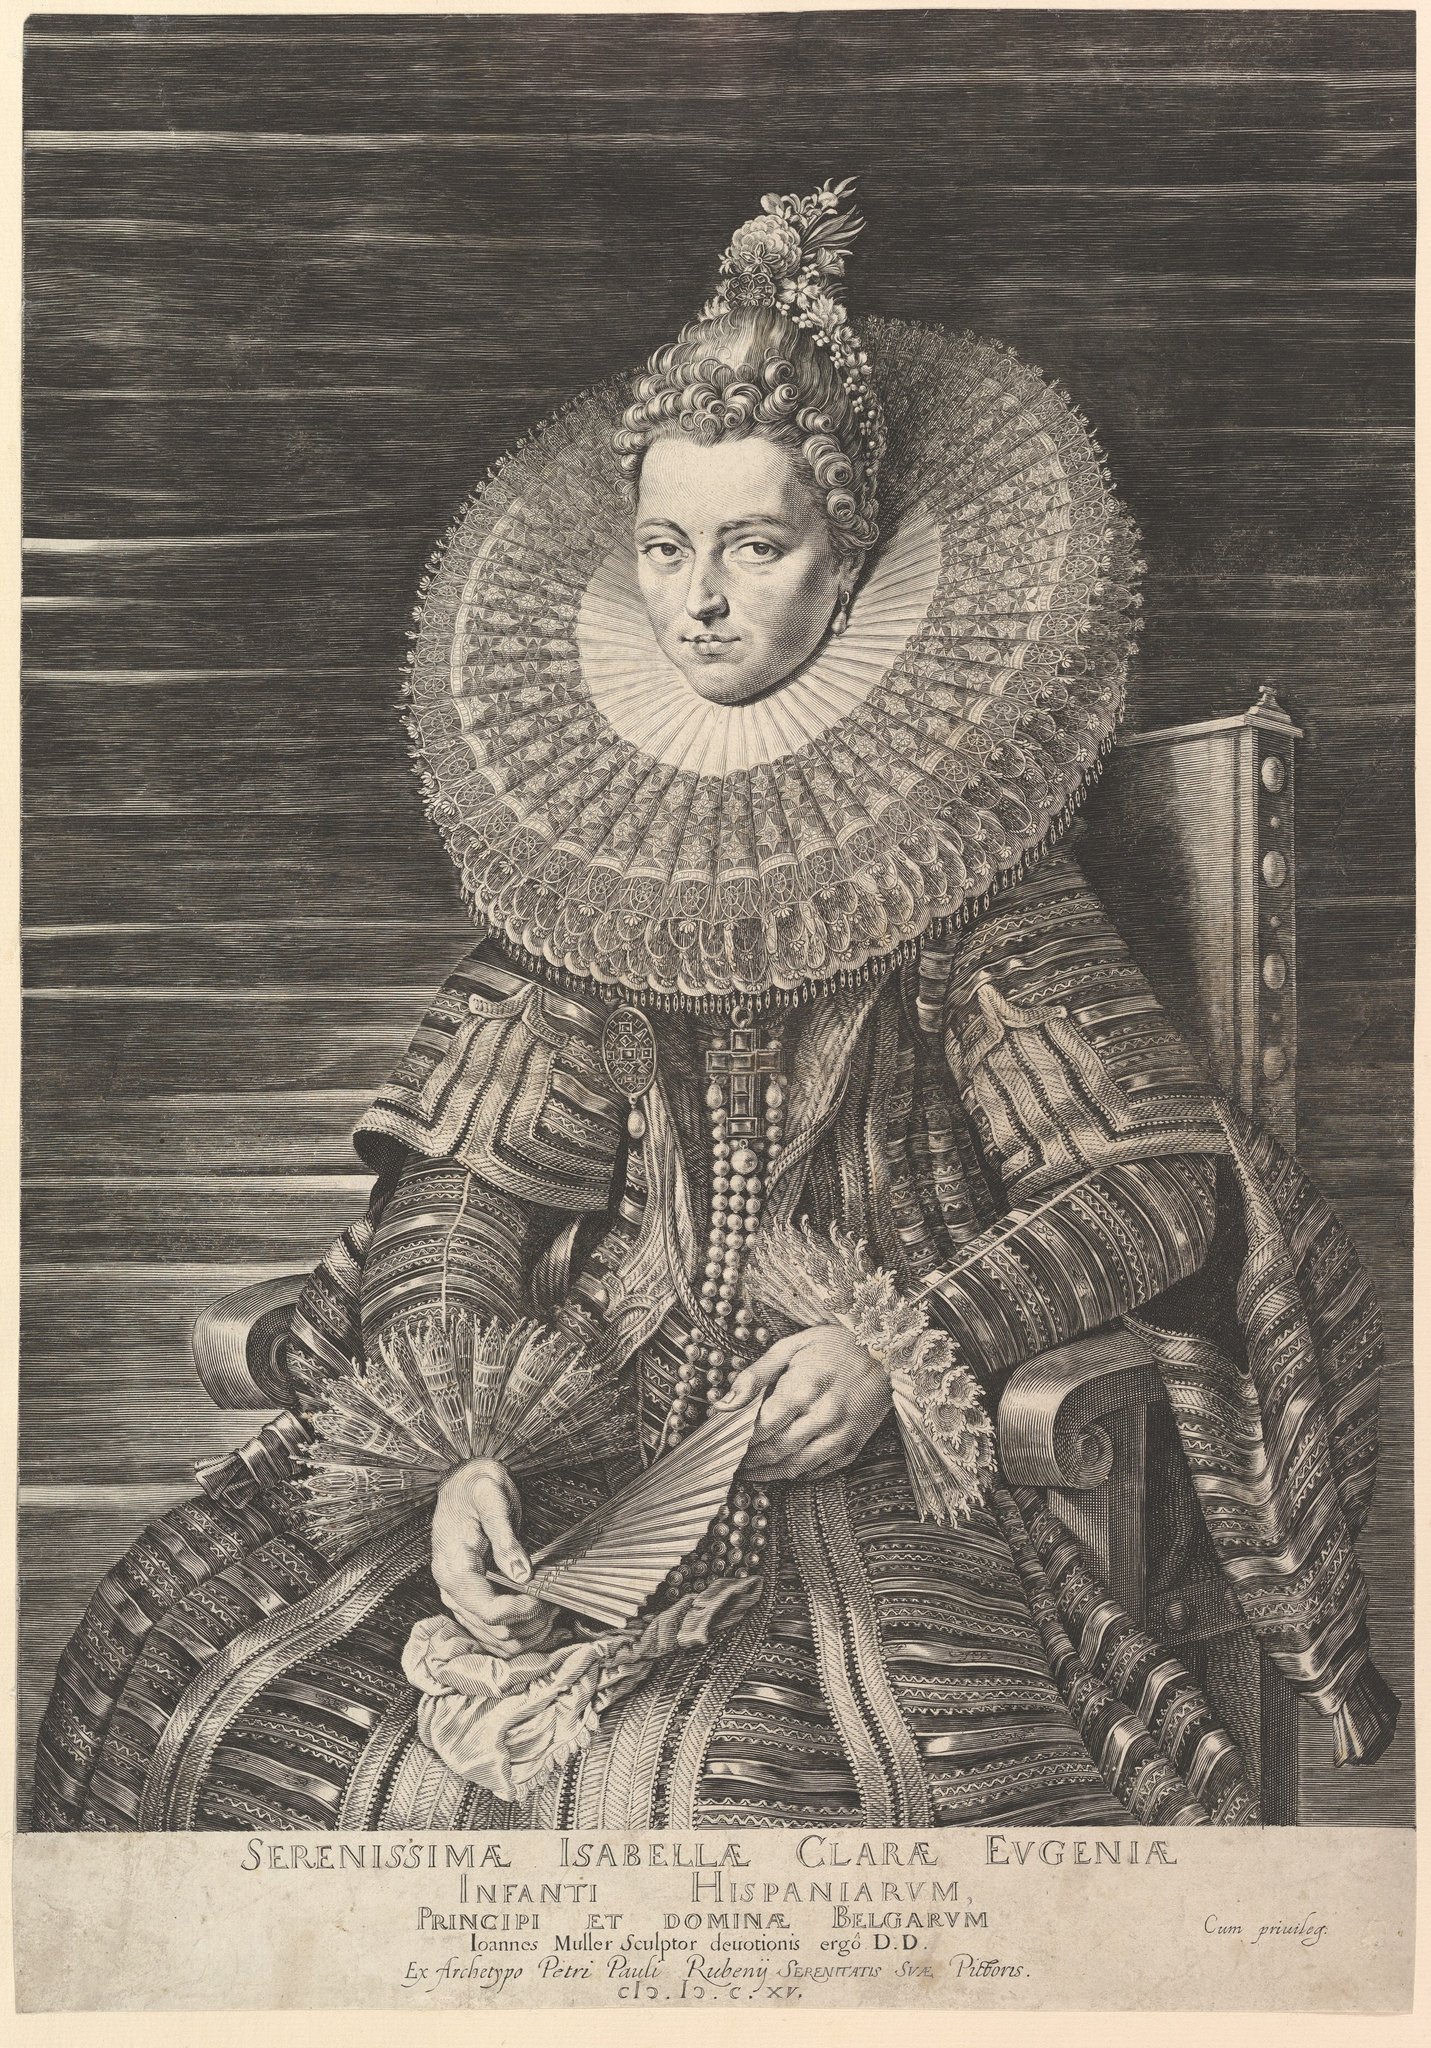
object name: print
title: Portrait of the Infanta Isabella Clara Eugenia, Sovereign of the Southern Netherlands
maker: jan muller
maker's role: artist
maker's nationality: netherlandish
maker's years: 1571-1628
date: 1615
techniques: engraving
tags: fans,portraits,women